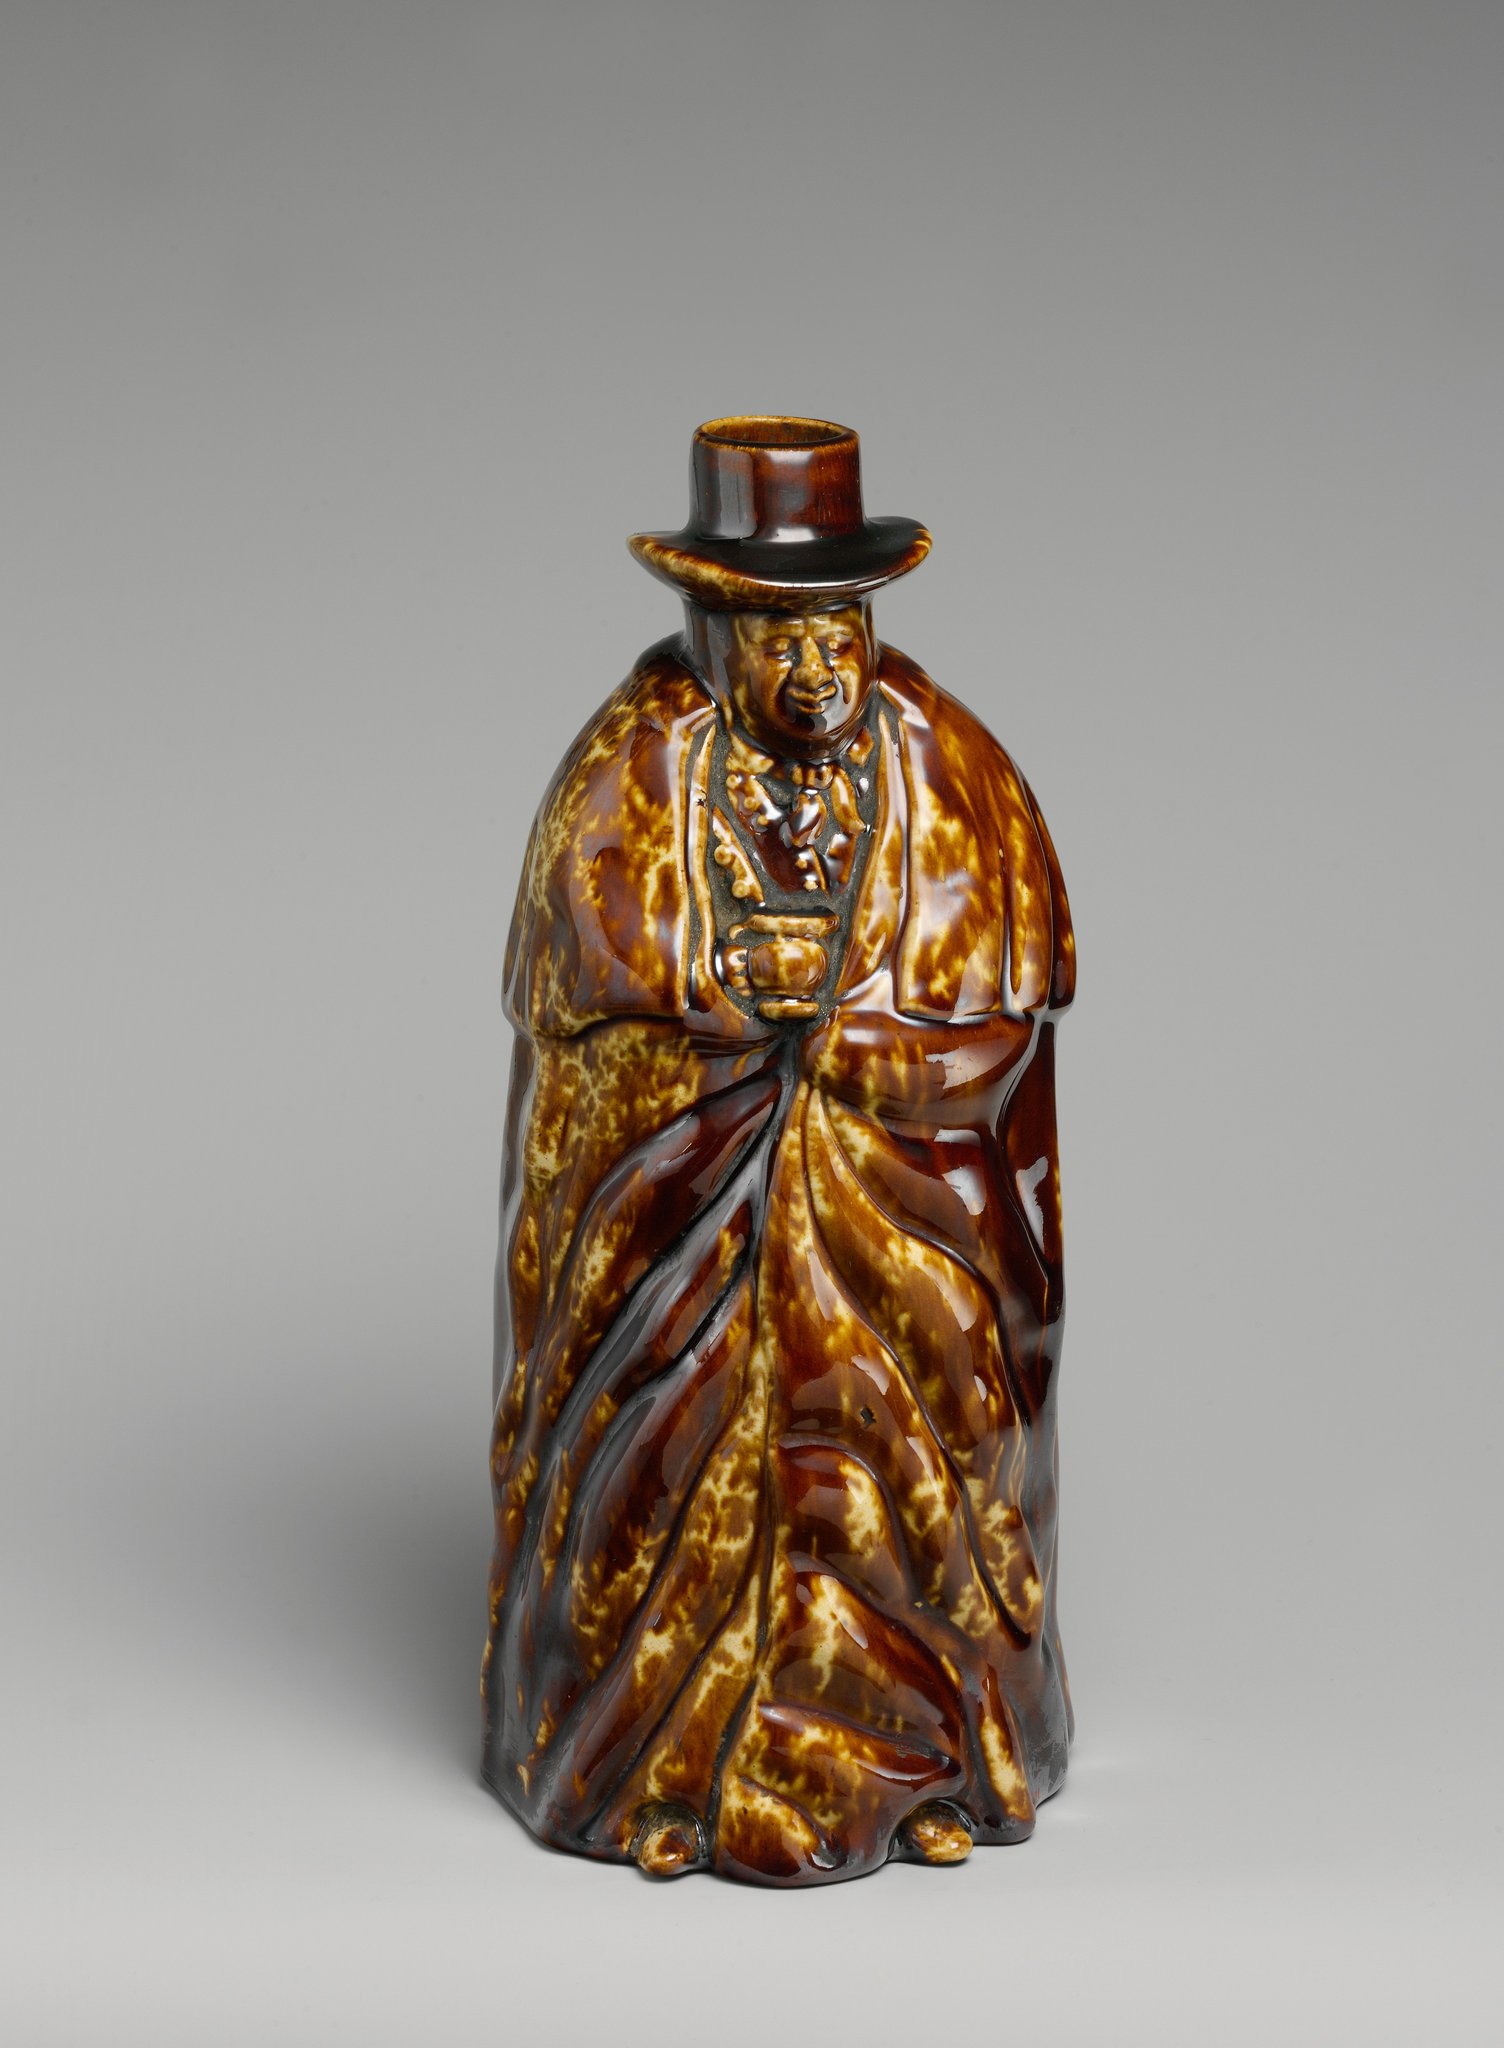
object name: bottle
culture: american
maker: daniel greatbatch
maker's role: designer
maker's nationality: british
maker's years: 1838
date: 1849-1858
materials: earthenware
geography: united states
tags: men